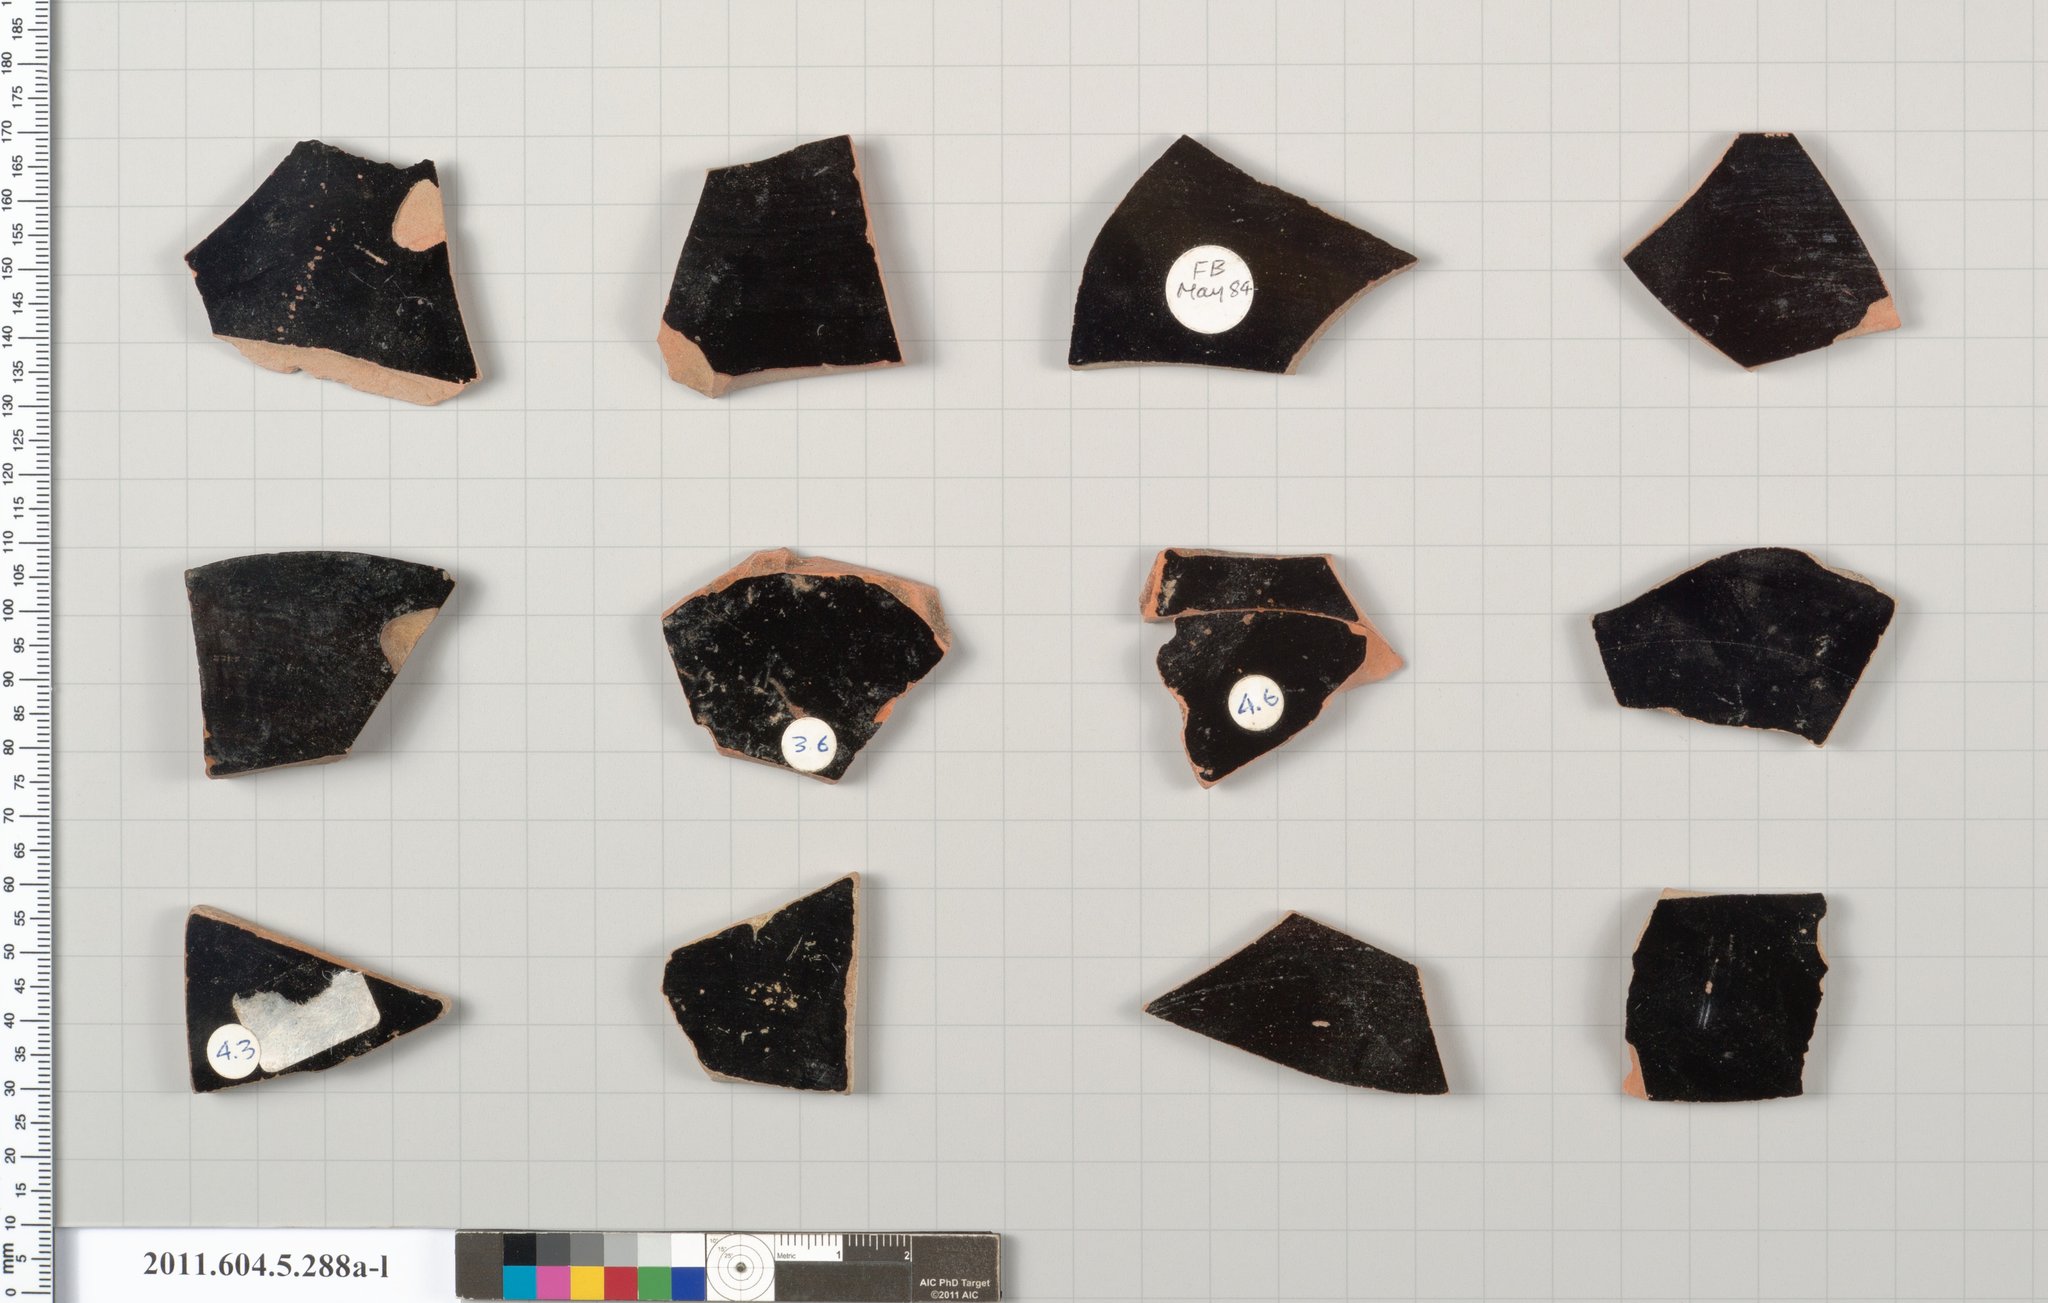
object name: kylix fragment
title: Terracotta fragments of kylikes (drinking cups)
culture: greek, attic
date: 600-401 BCE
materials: terracotta